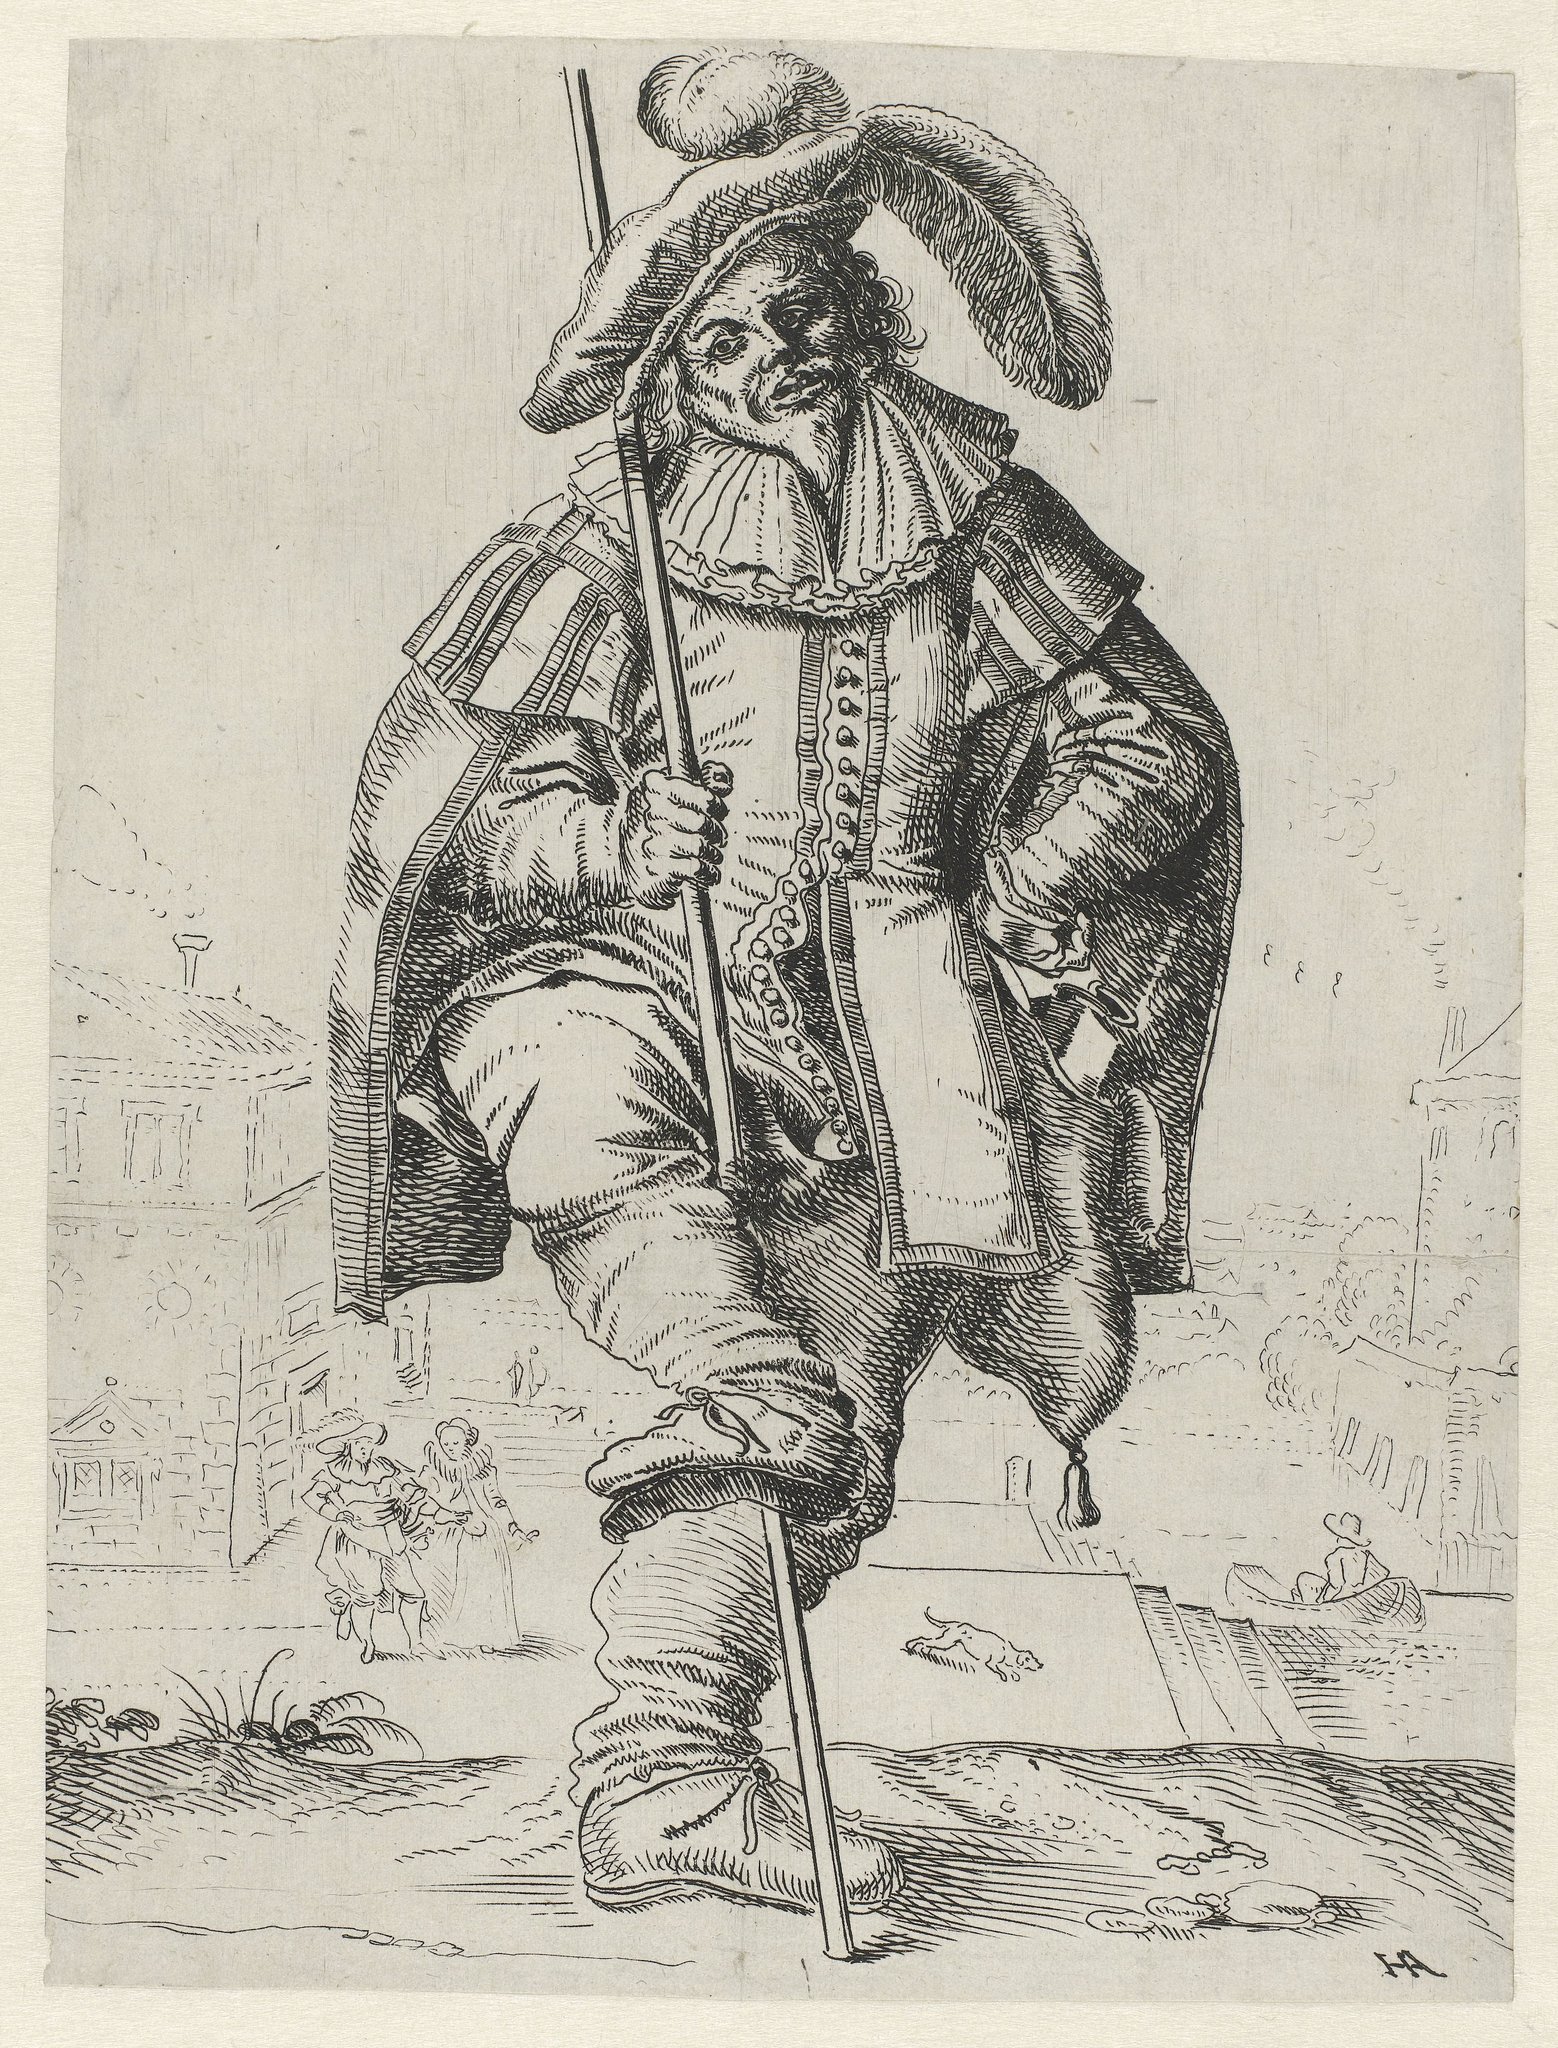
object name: print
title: Zelfportret als toneelspeler in de rol van Peter Leberwurst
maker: hans ammon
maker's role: print maker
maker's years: -1632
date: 1610-1632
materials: paper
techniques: etching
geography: nuremberg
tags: print maker, hans ammon, portrait of artiste (dancer, actor, etc.), head-gear: beret (+ men's clothes), cape (+ men's clothes), shoes, sandals (+ men's clothes), portrait, self-portrait of artist, neck-gear: collar (+ men's clothes)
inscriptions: collector's mark: Lugt 2228, collector's mark: Lugt 2760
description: Portret ten voeten uit, met staf, muts met veer en opgetrokken been.